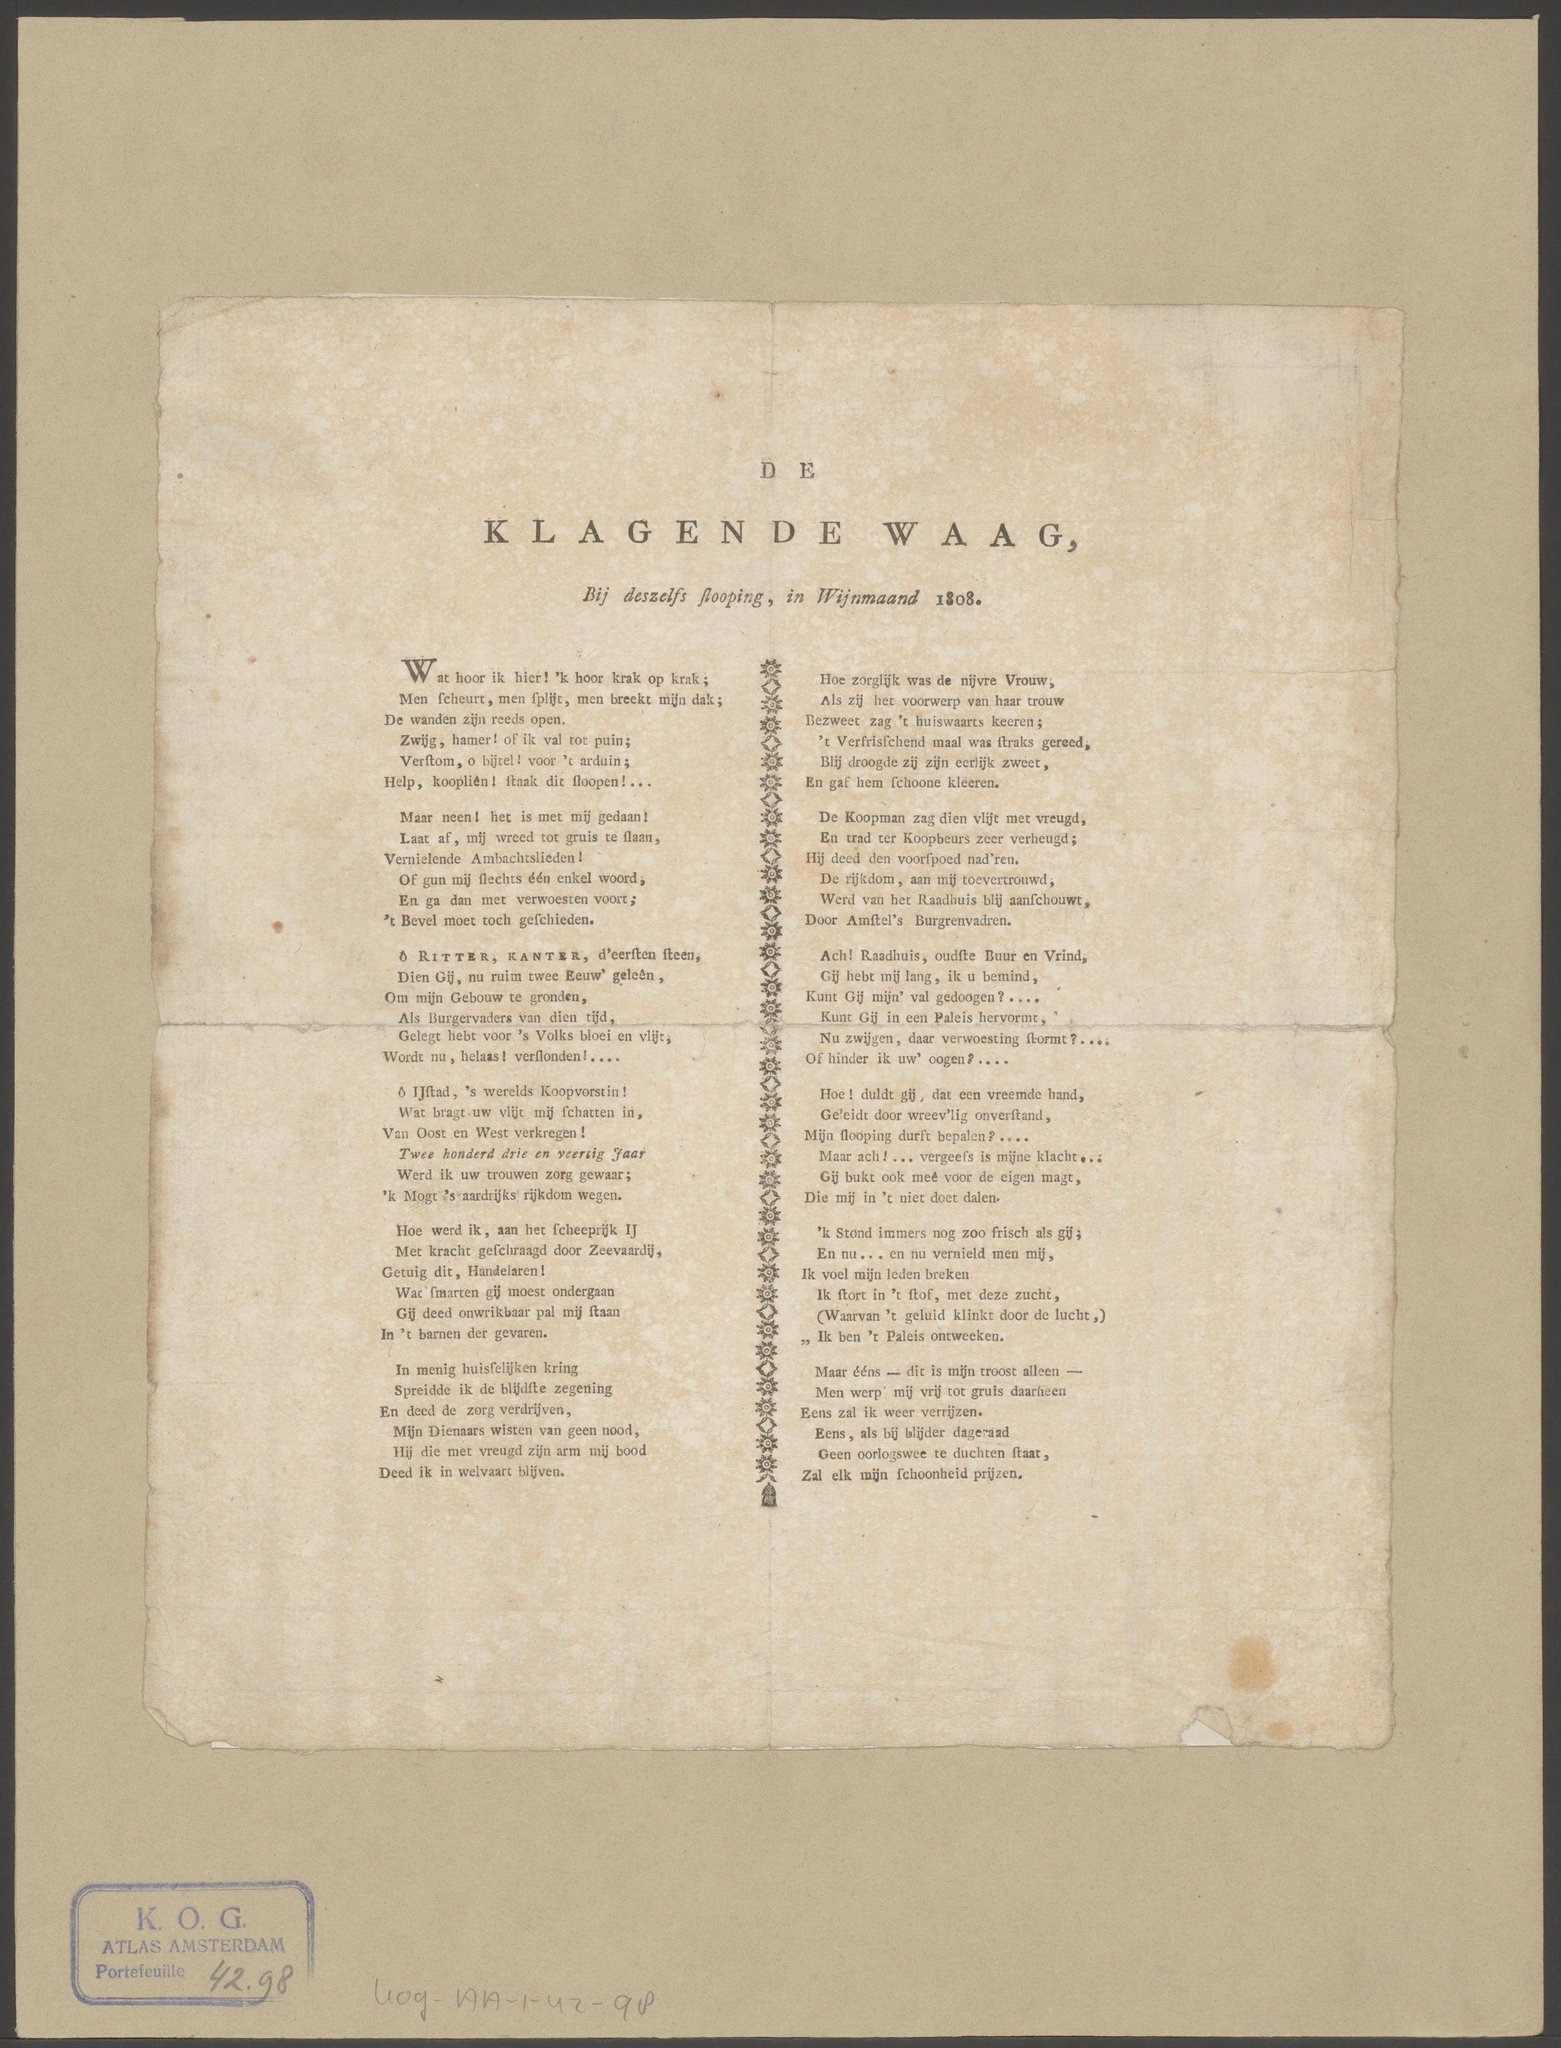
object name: text sheet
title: De Klagende Waag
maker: Anonymous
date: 1808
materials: paper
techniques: letterpress printing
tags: weigh-house, amsterdam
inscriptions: collector's mark: Lugt 1641b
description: Vers in twee kolommen. Onderwerpsrubriek binnen de Atlas Amsterdam: Markten, handel: C. Veemen, Waaggebouwen.